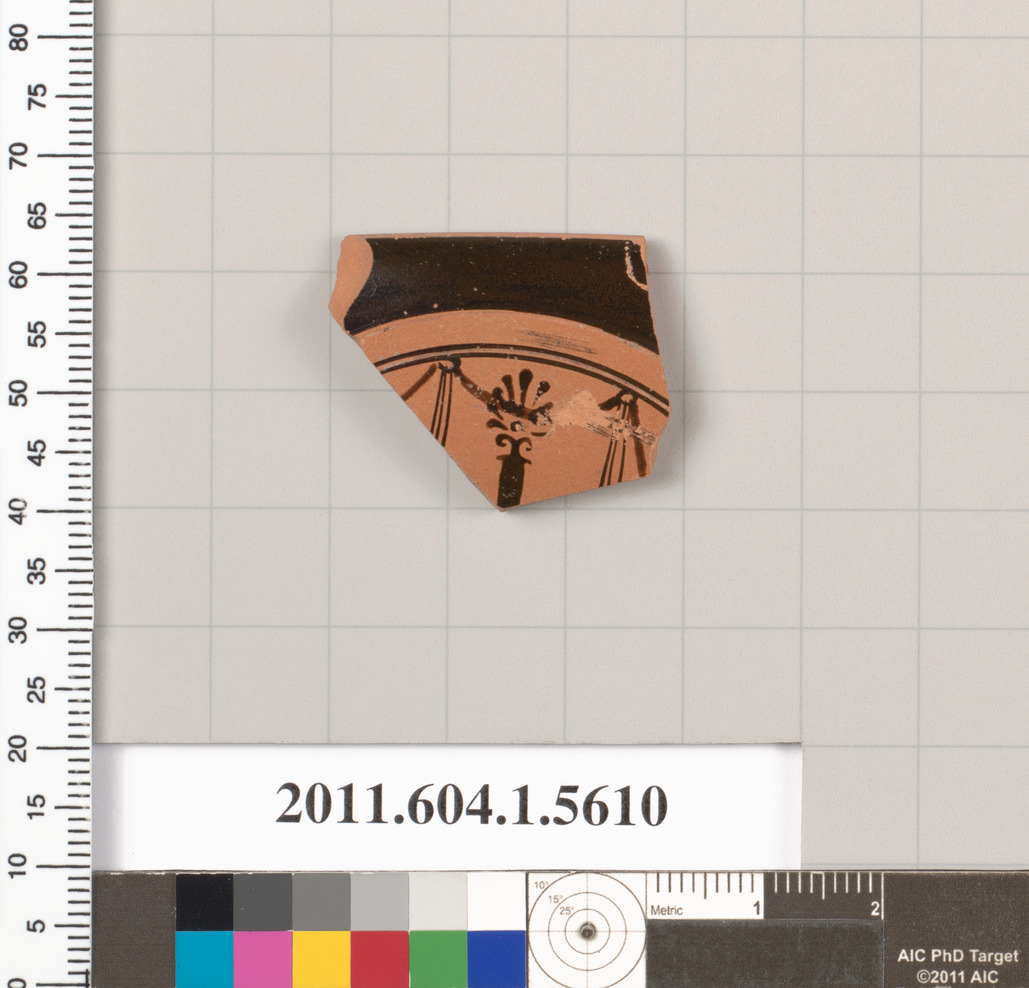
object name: kylix fragment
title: Terracotta rim fragment of a kylix (drinking cup)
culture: greek, attic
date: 520-500 BCE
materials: terracotta